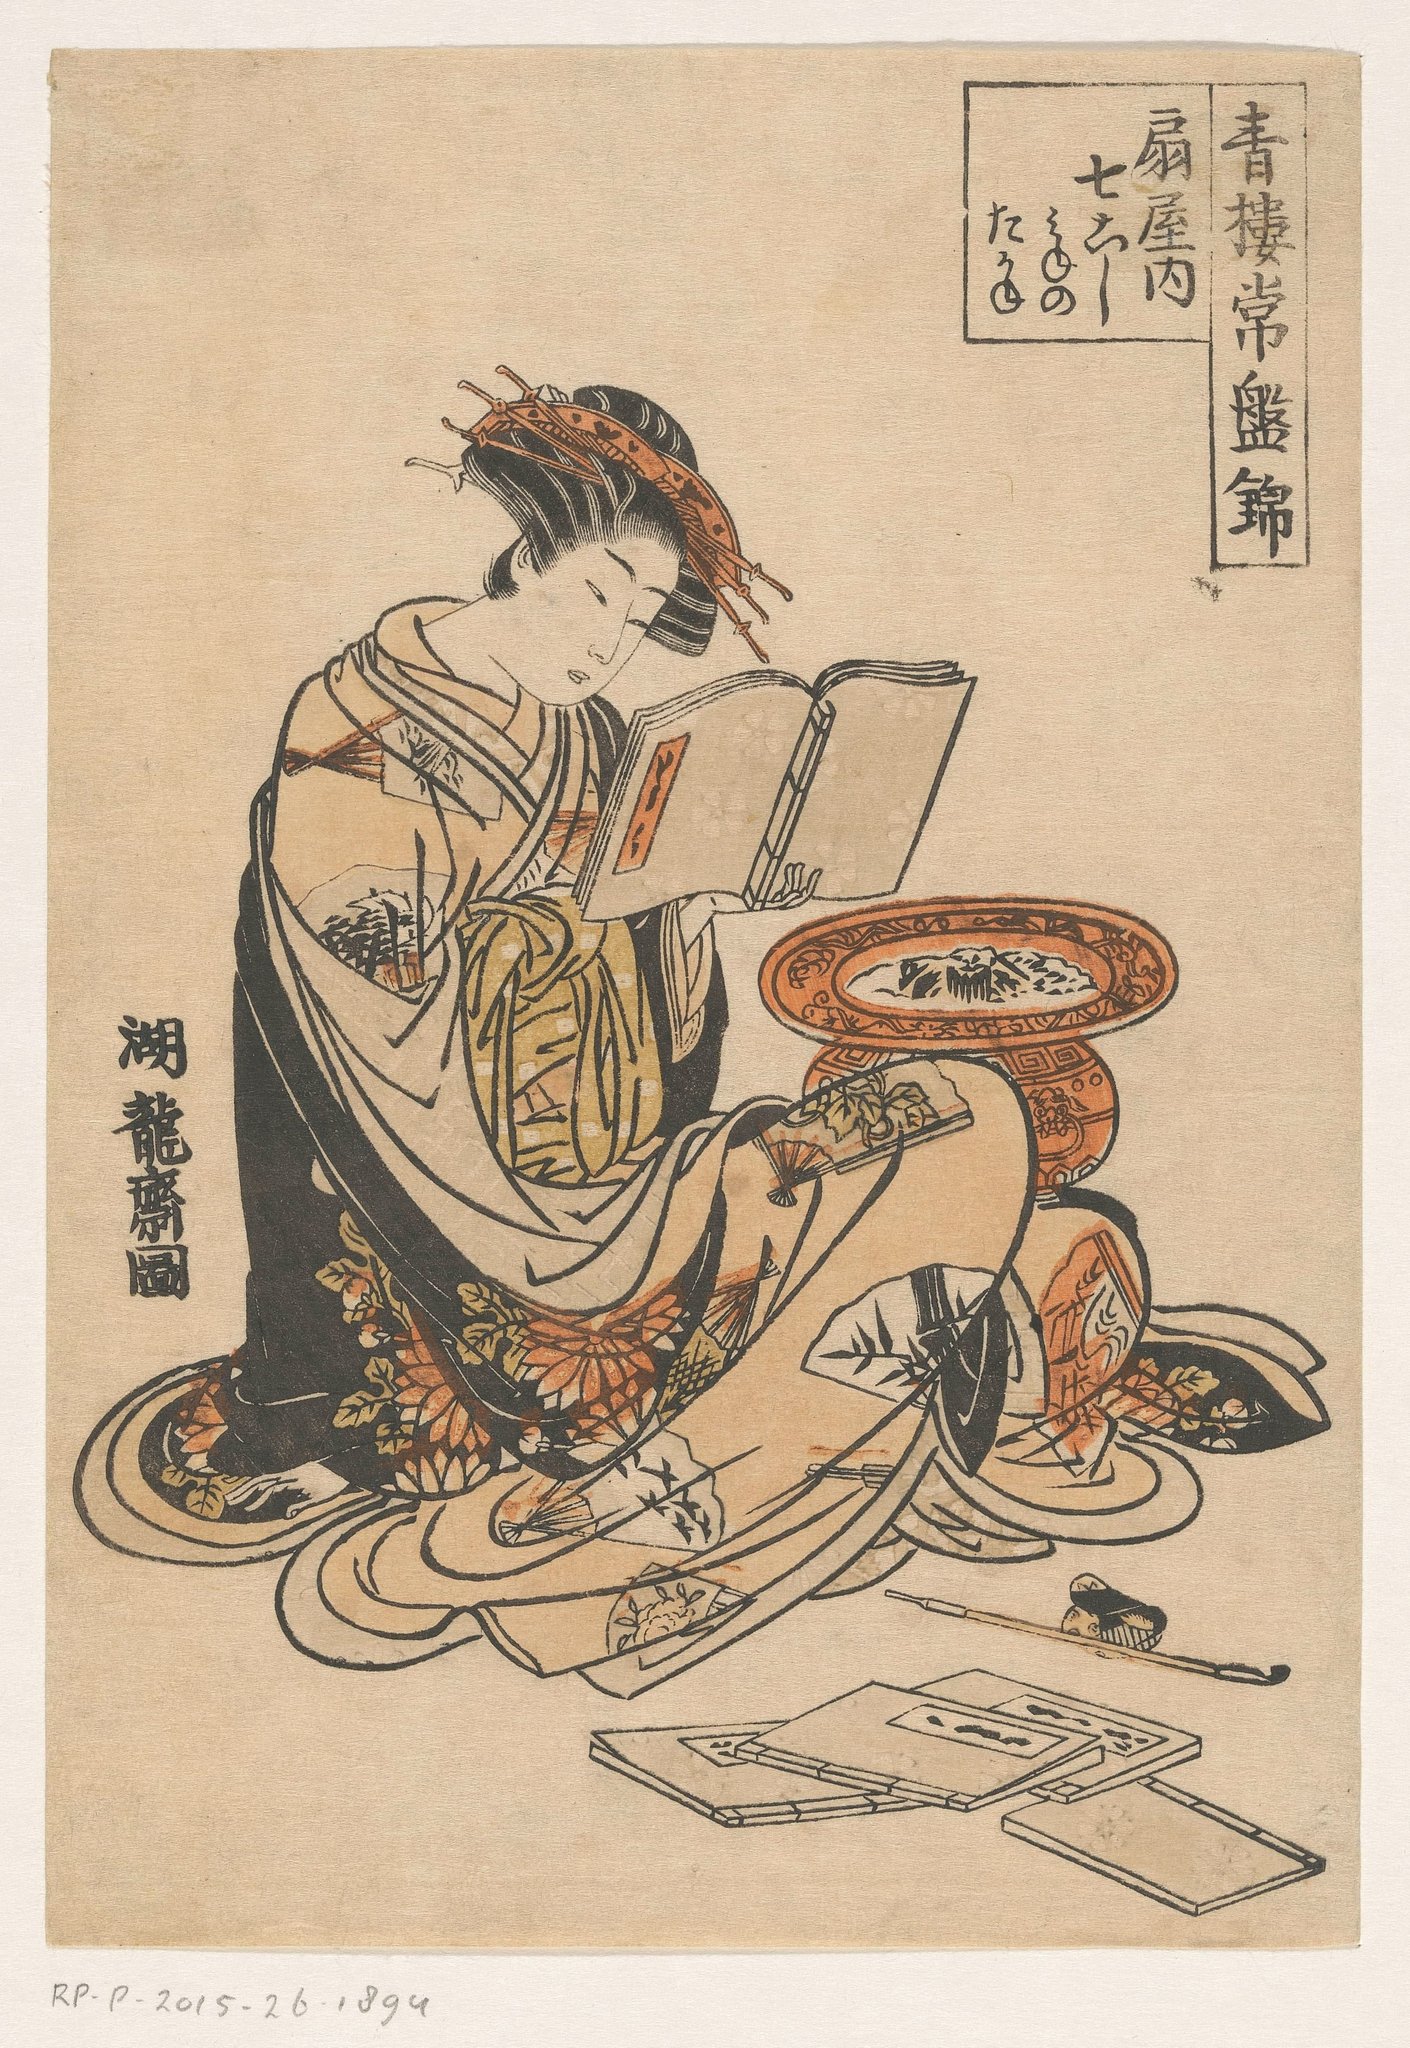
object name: print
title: Lezende vrouw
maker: isoda kôryûsai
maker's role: print maker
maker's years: 1735-1790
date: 1764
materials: paper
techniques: woodcut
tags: reading